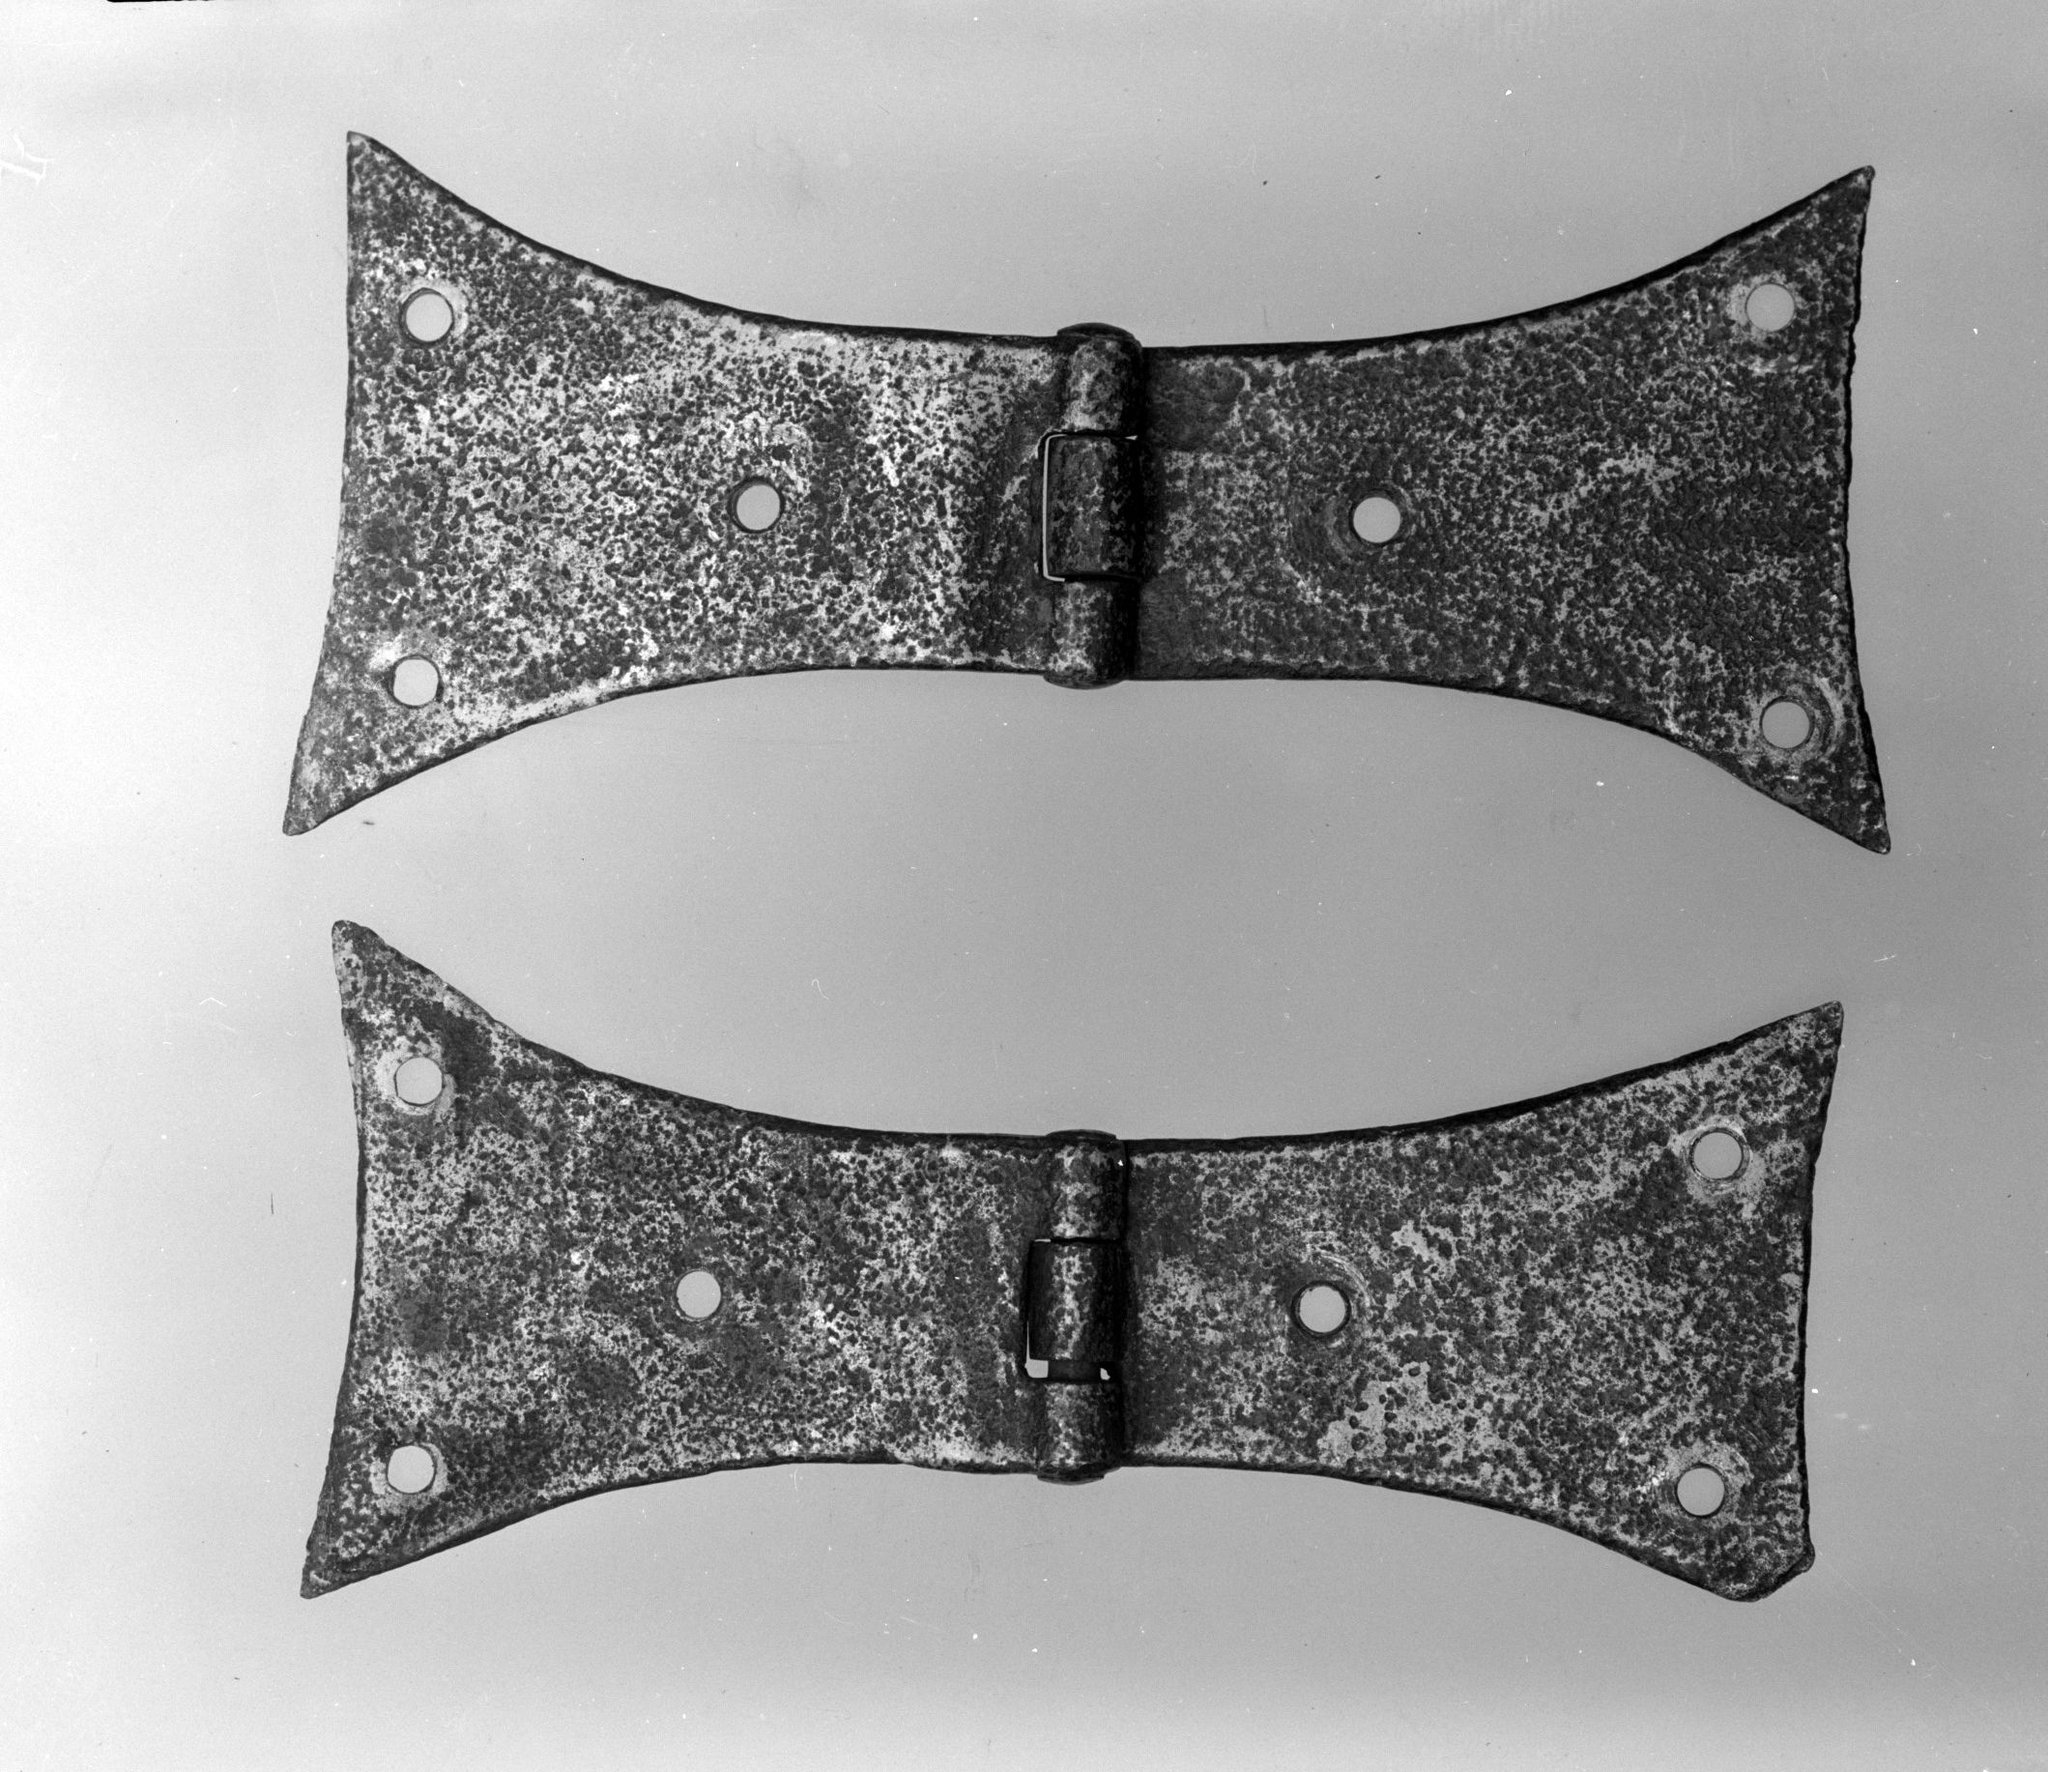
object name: hinge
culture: american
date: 1700-1800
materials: iron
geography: united states